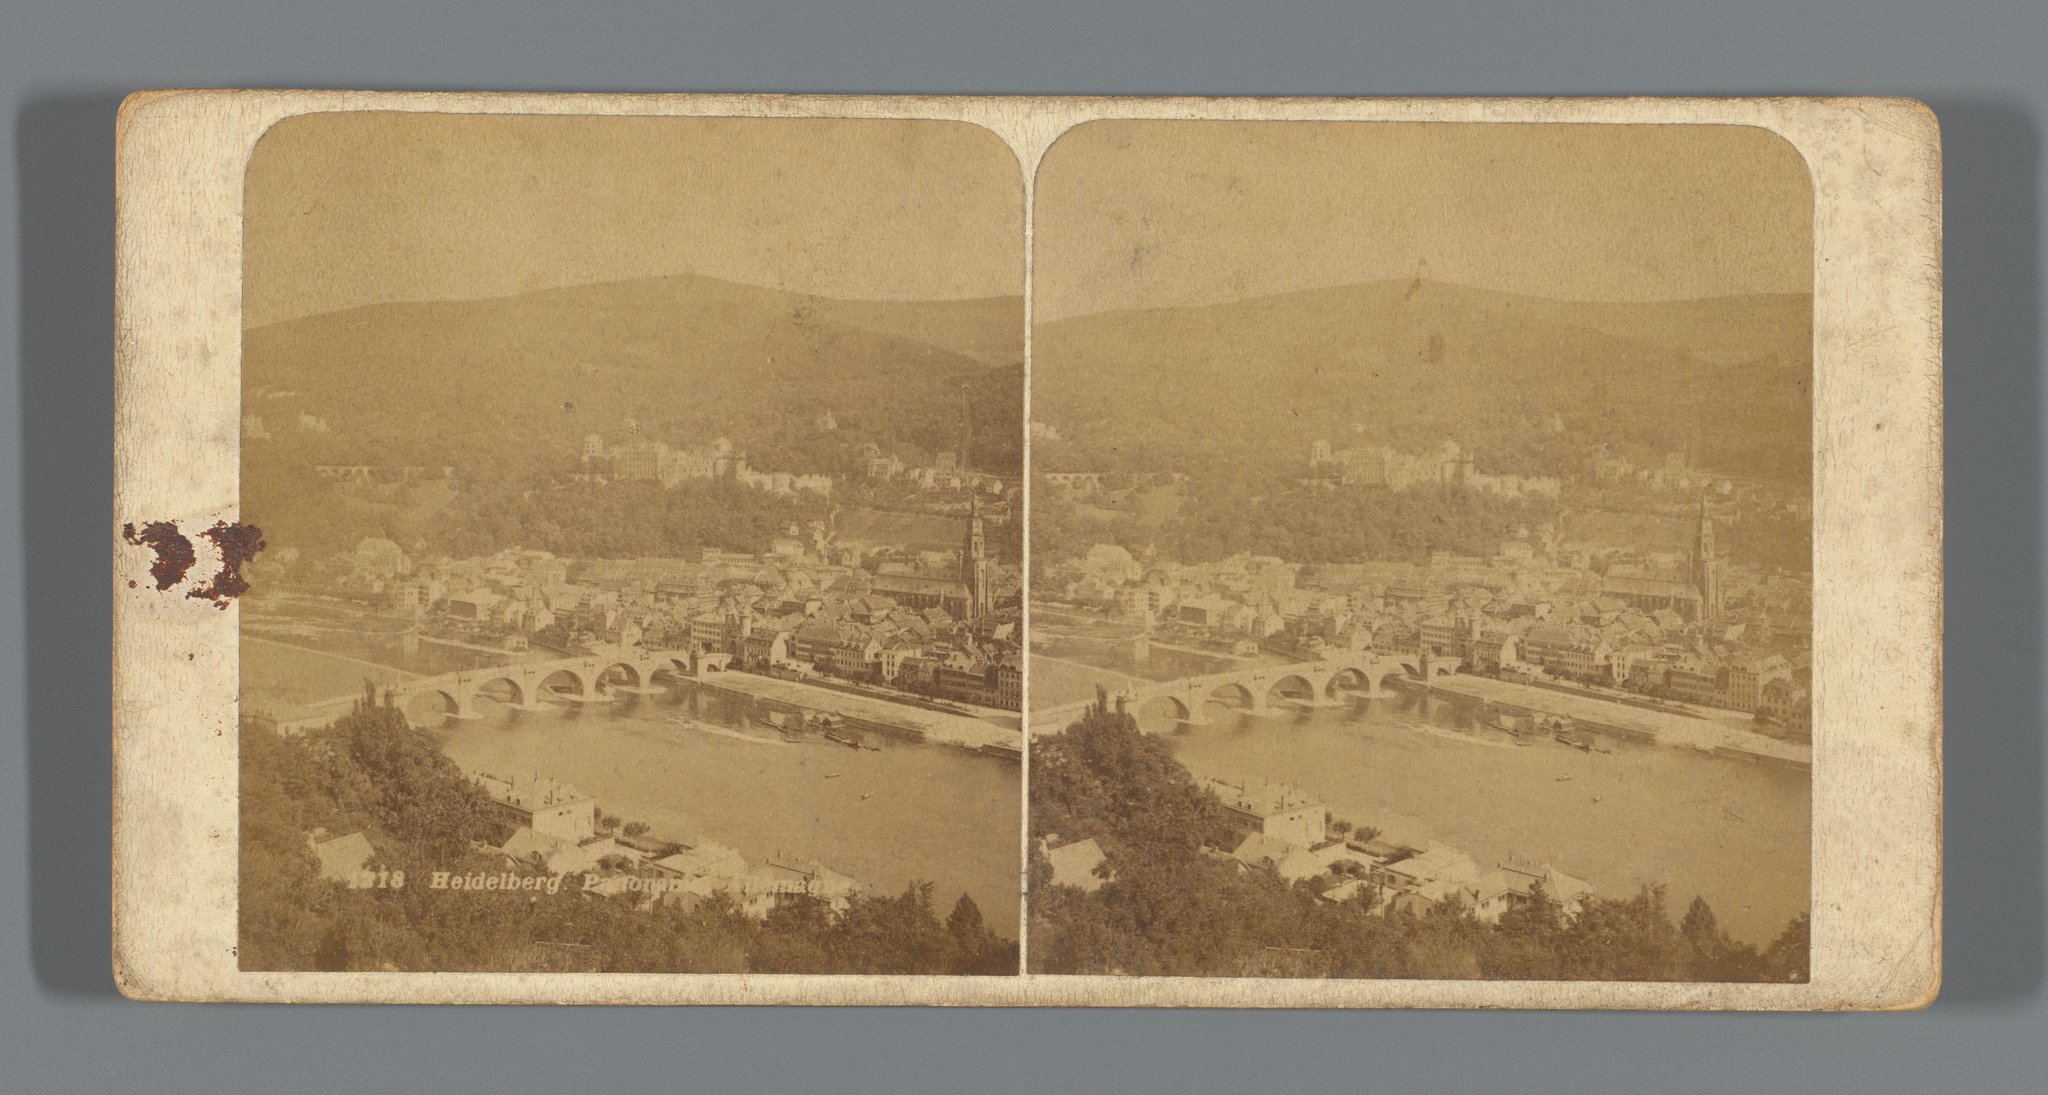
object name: stereograph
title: Aardrijkskundige Beeldengalerij, verzameld door M.J. Broekhuijsen, Hoofd eener school te Amsterdam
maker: martien johan broekhuijsen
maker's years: 1871-1956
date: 1905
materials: photographic support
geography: amsterdam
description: Onderdeel van een groep van 52 stereofoto's gebruikt in het lager onderwijs als aanvulling op schoolplaten. De gehele reeks bestond uit 274 nummers in 10 categorieën (A t/m K).